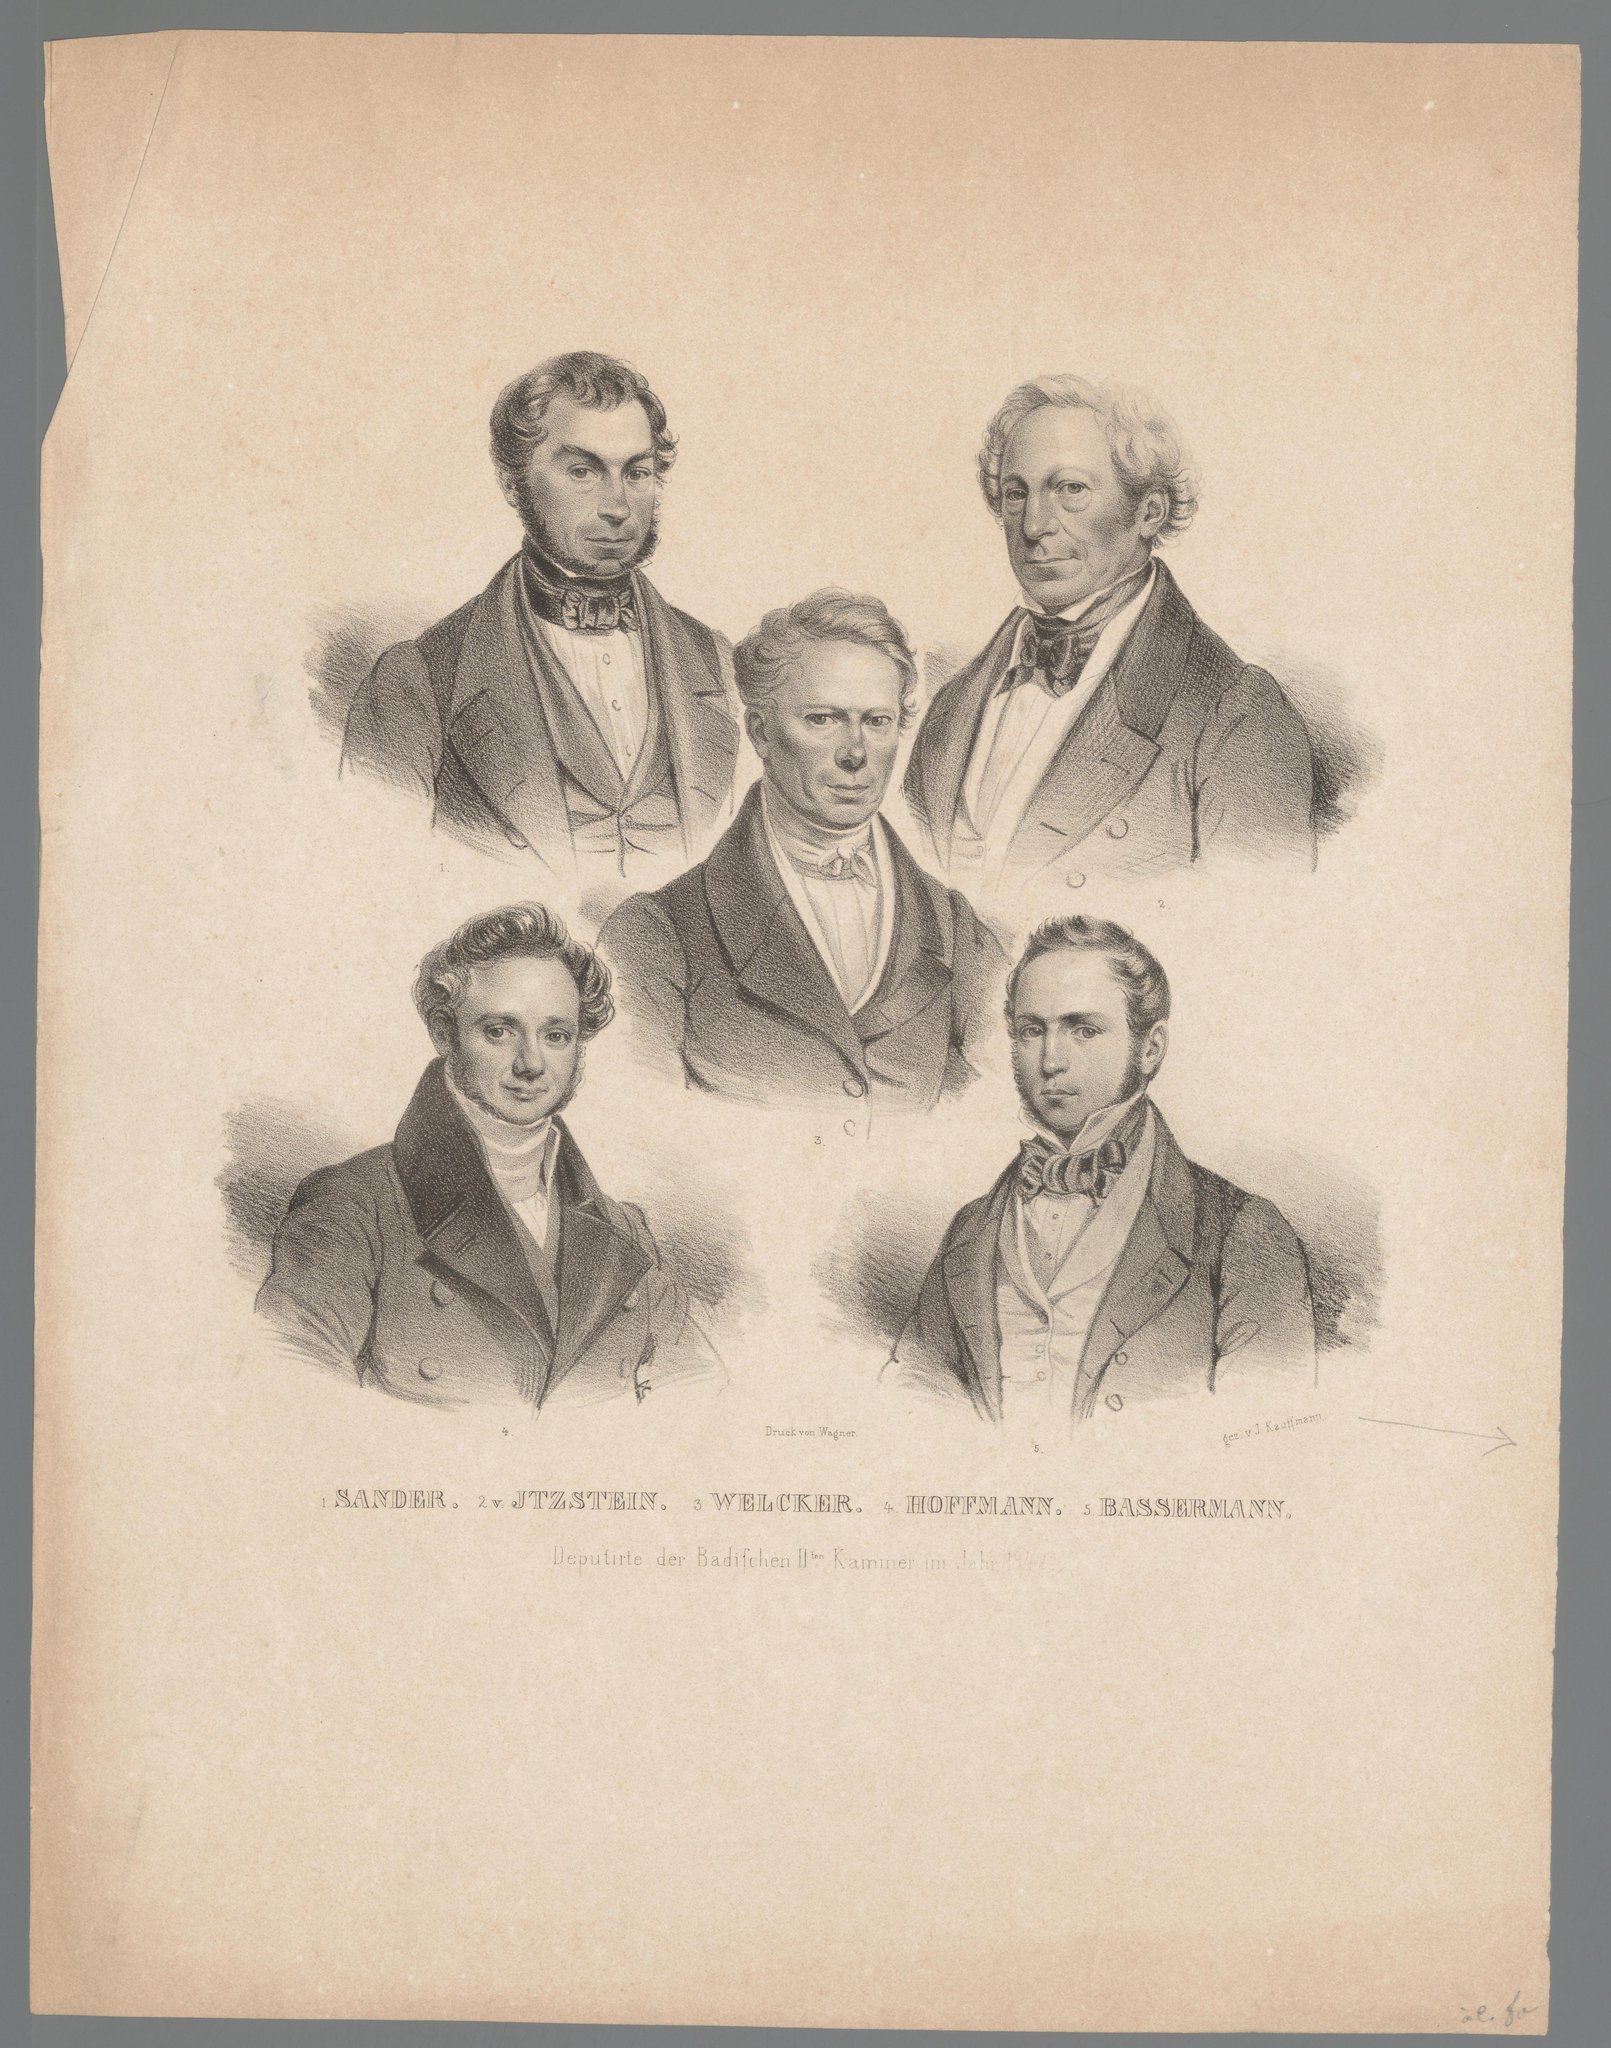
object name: print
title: Vijf portretten van de gedeputeerden van de Badense Tweede Kamer in 1842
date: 1842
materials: paper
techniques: lithograph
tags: politician, adult man (+ five persons), historical persons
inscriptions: collector's mark: Lugt 2228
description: De geportretteerden zijn: Adolf Sander, Johann Adam von Itzstein, Carl Theodor Welcker, Carl Hoffmann en Friedrich Daniel Bassermann.